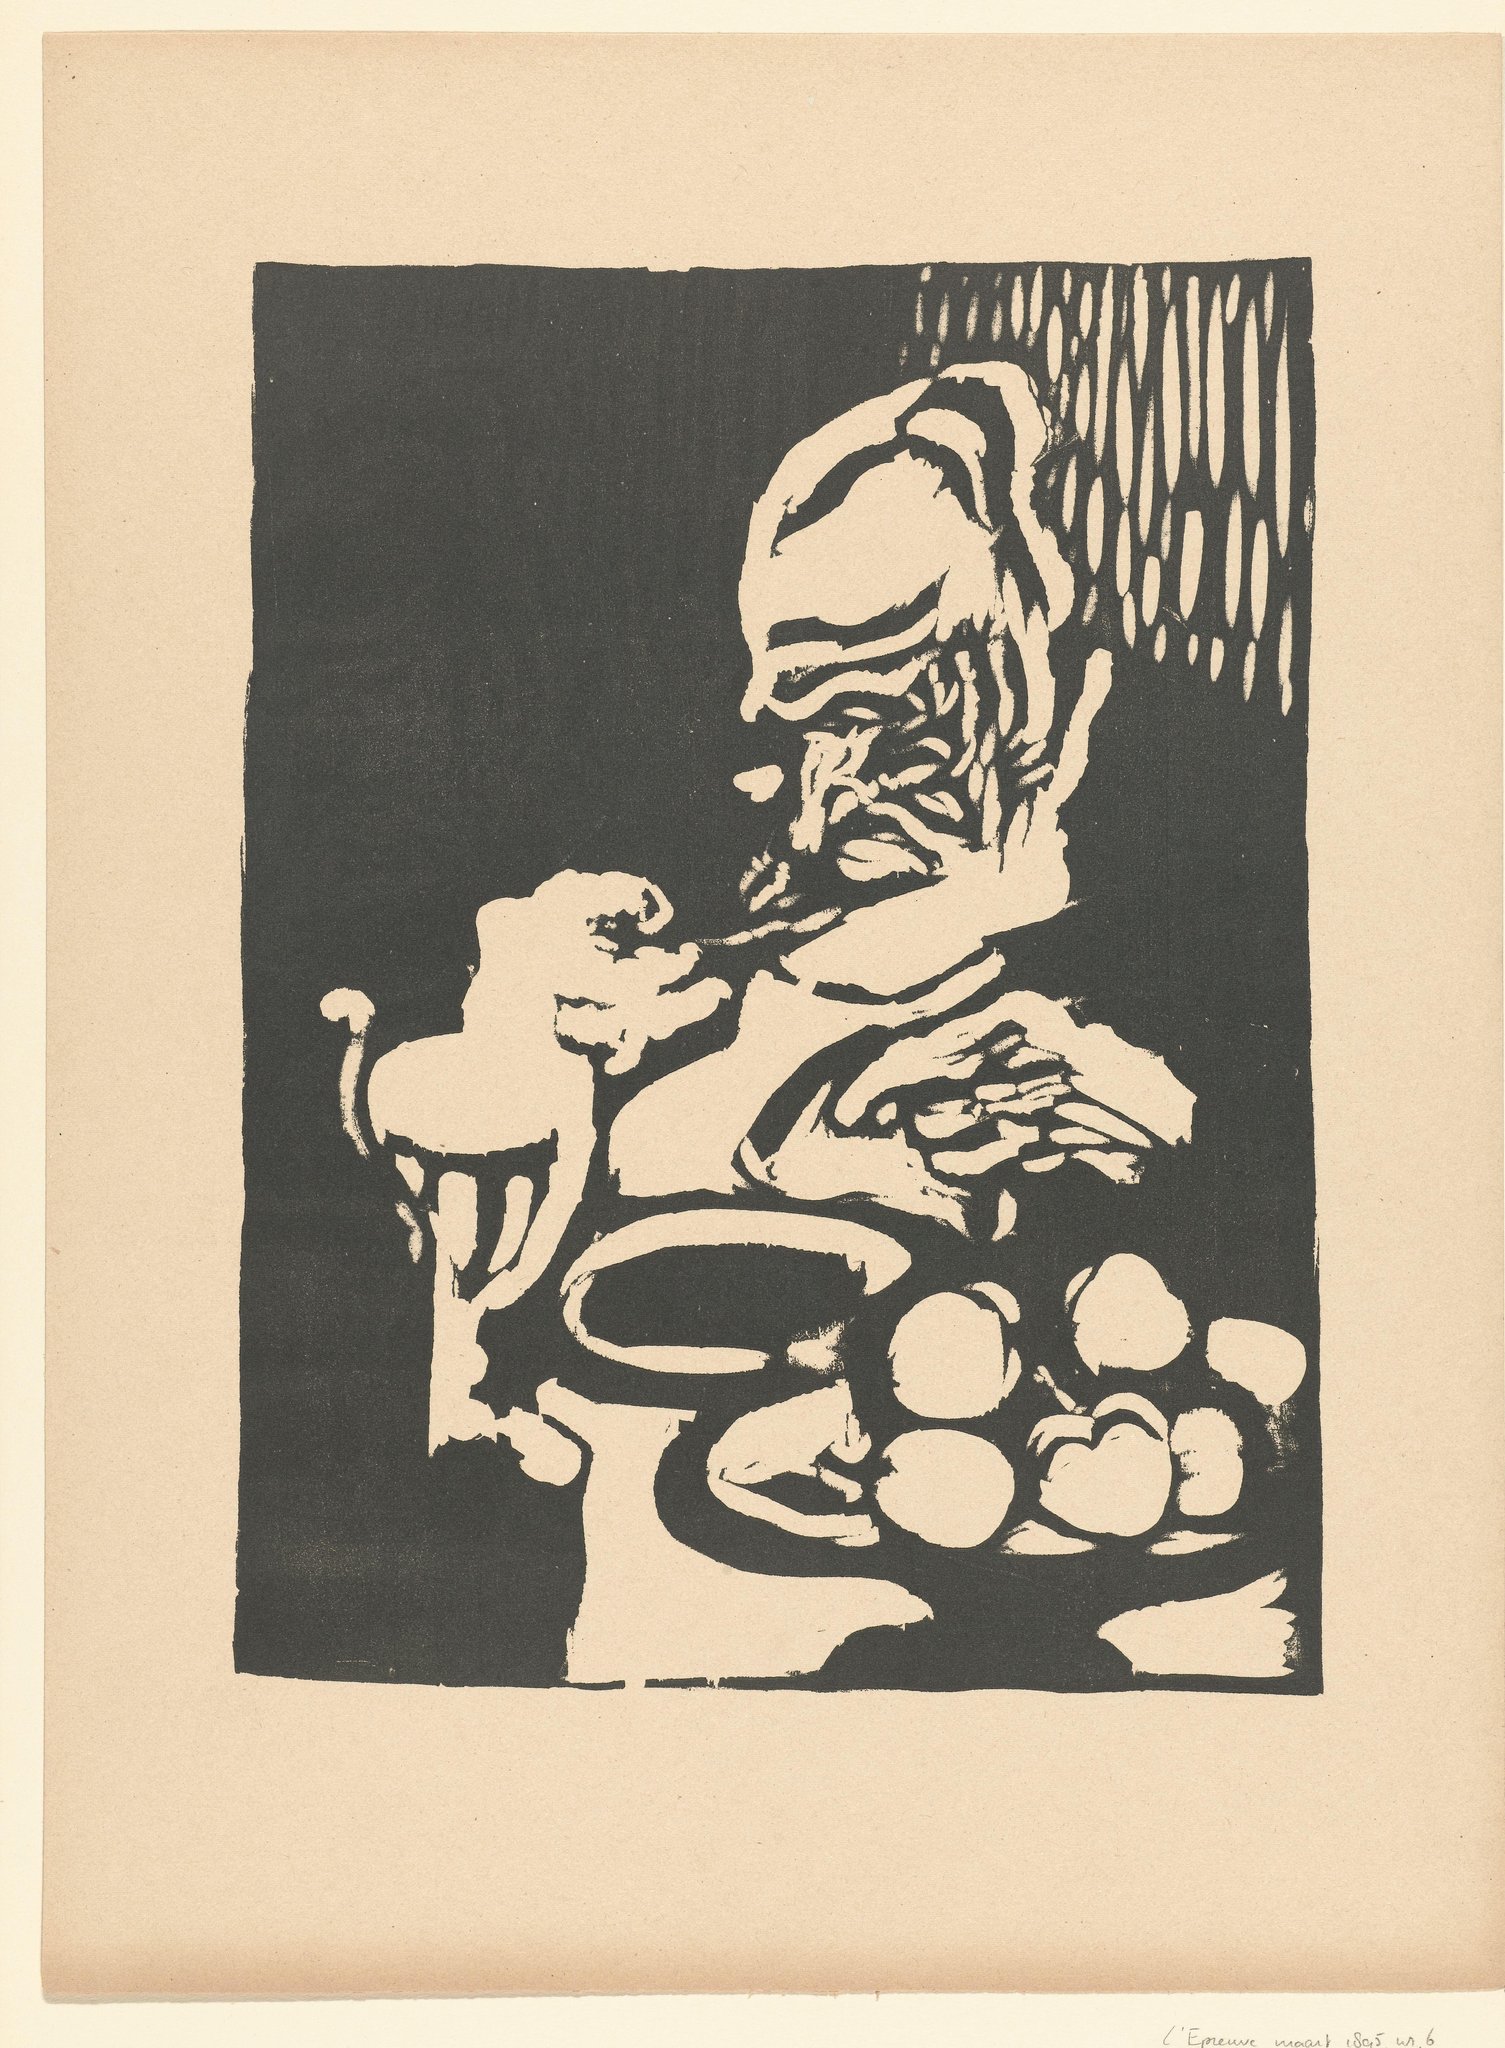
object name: print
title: A table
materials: paper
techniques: woodcut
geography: paris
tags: fruits, male sex; man, eating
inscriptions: collector's mark: Lugt 2760, collector's mark: Lugt 2228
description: Verschenen in album met tien originele prenten als supplement bij tijdschrift: L'Epreuve, maart 1895, prent nr. 6